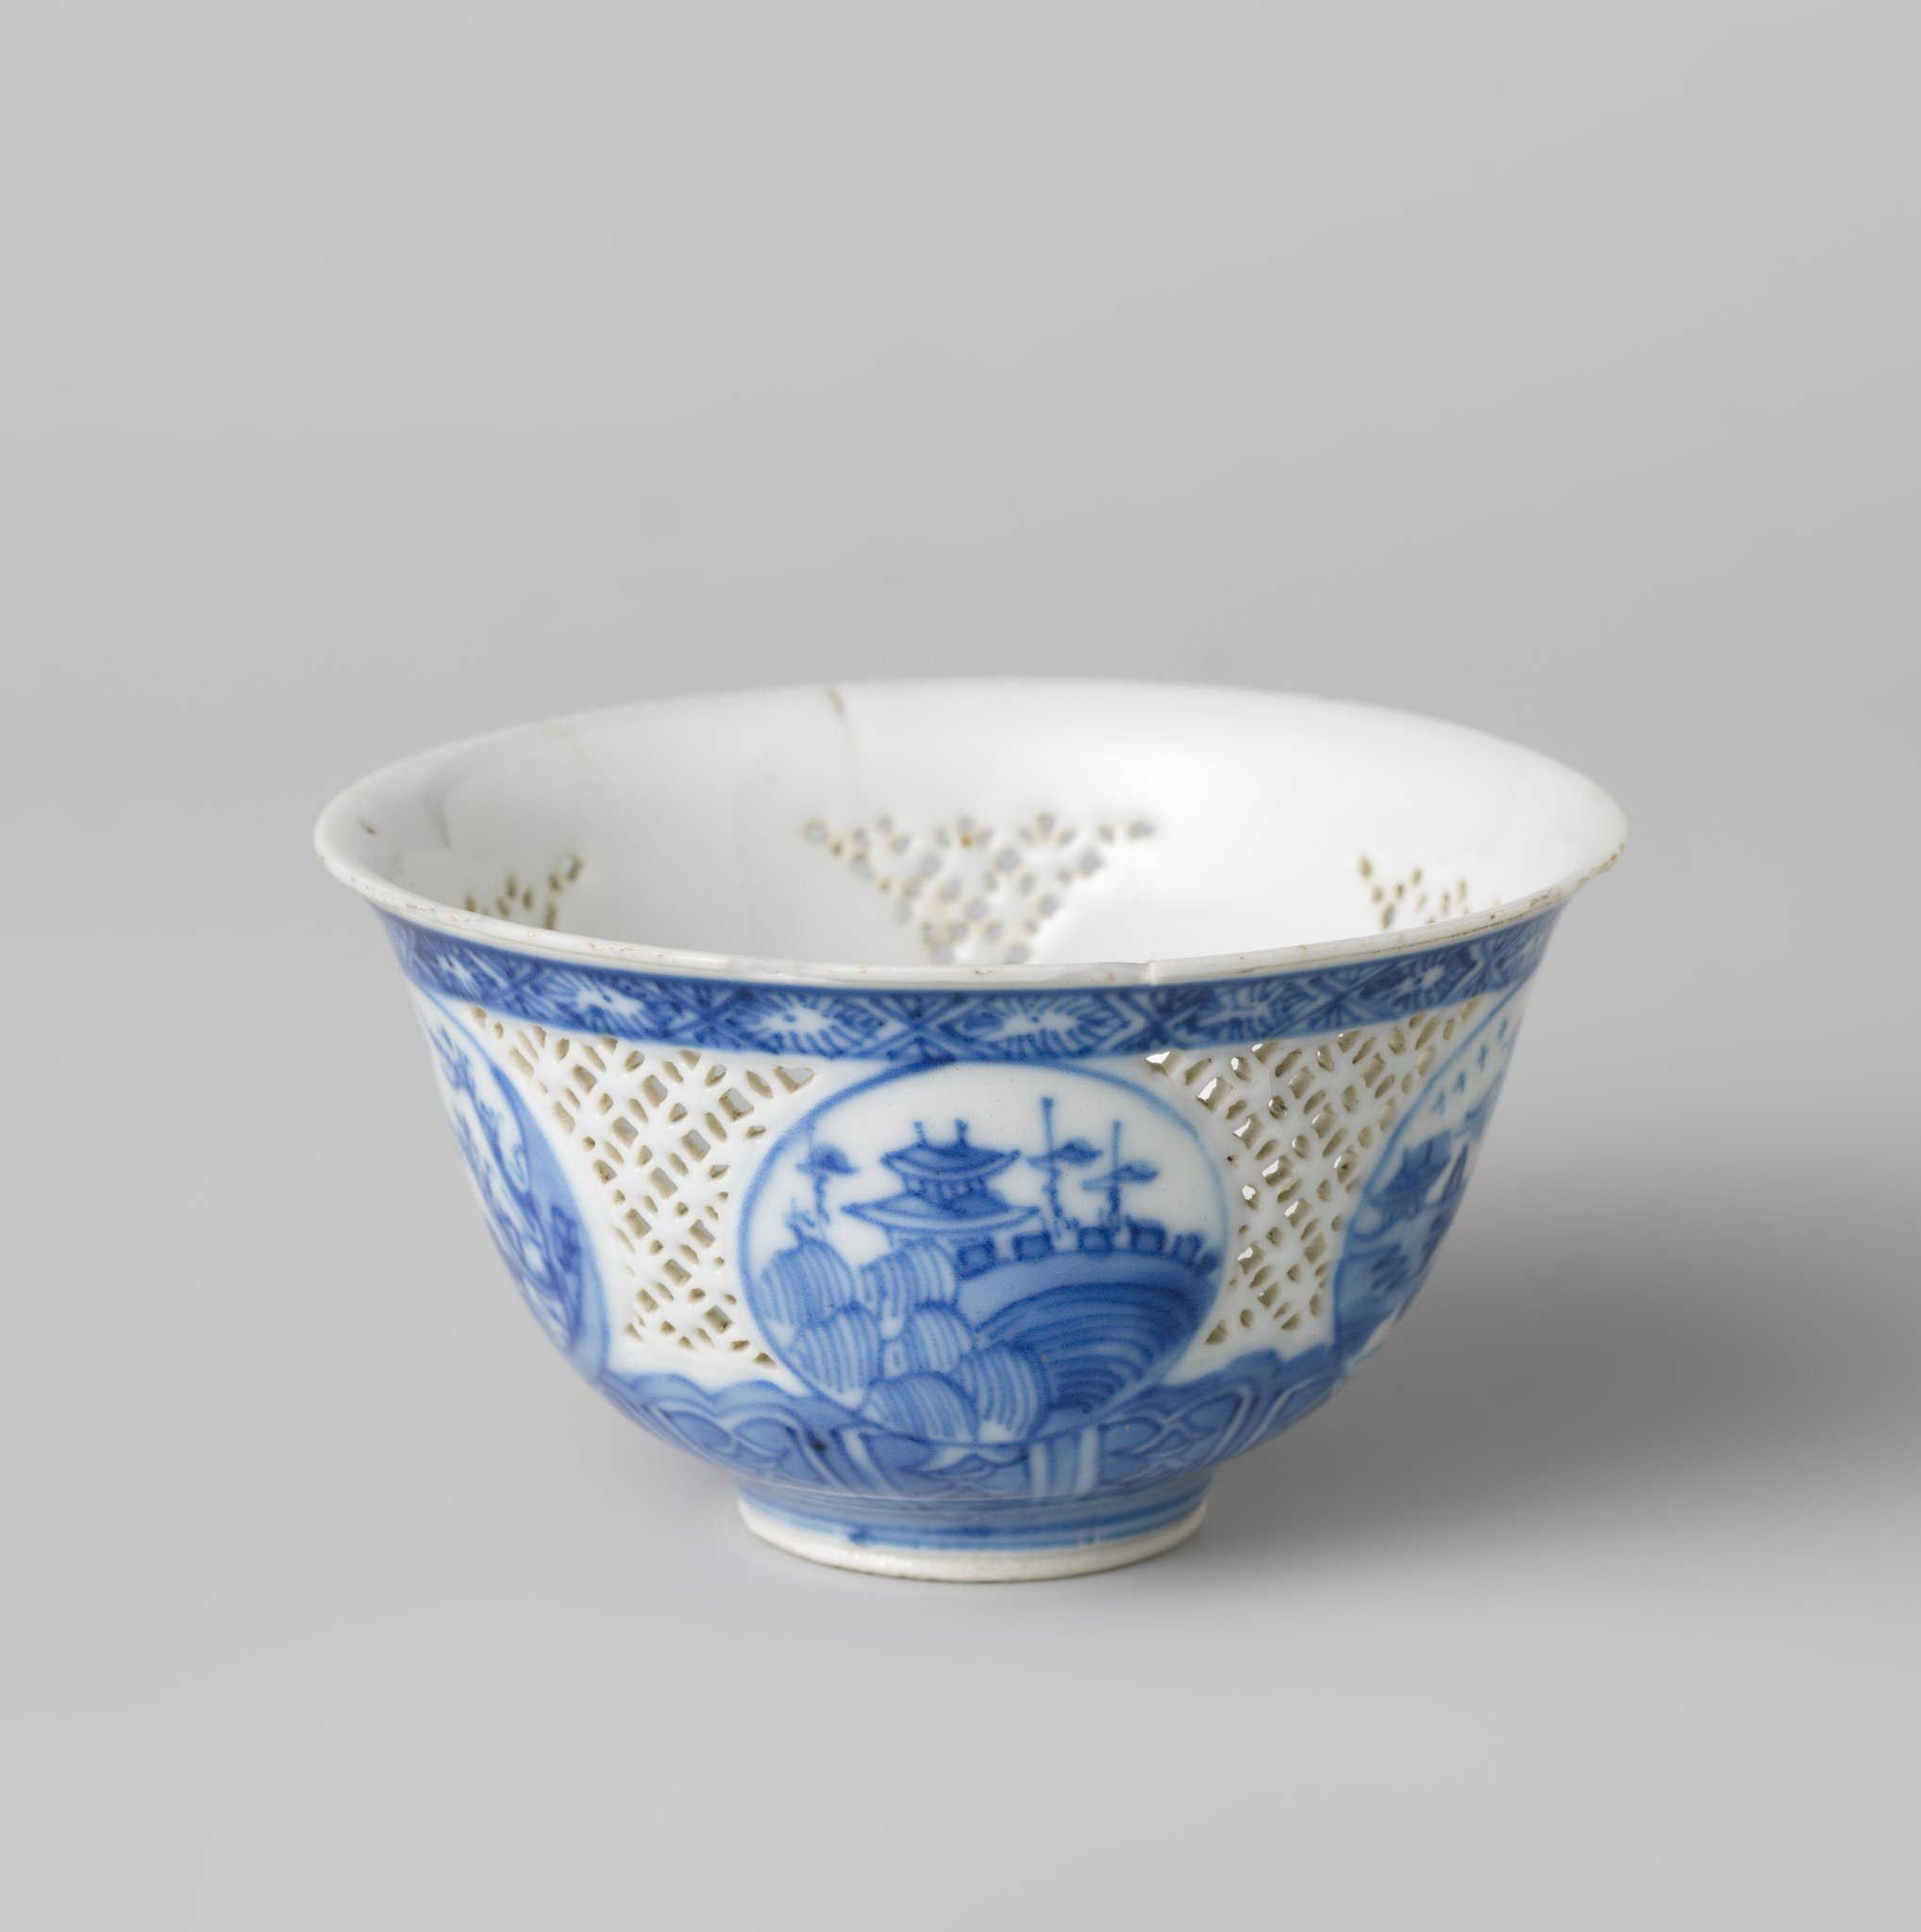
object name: cup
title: Bell-shaped bowl with pierced sides and water landscapes in medallions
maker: Anonymous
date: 1635-1650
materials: cobalt, glaze, paint, porcelain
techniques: embroidery, firing, turning, vitrification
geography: china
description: Klokvormige kom van porselein, beschilderd in onderglazuur blauw. De wand van de kom is opengewerkt met daarin uitgespaard medaillons. In de medaillons rivierlandschappen met bomen, bergen en paviljoens. De onderzijde van de wand met een band gestileerde bladmotieven. Op de buitenrand een band met servetwerk. De onderzijde en de buitenrand zijn ongeglazuurd. Enkele chips in de rand. Overgangsporselein in blauw-wit.